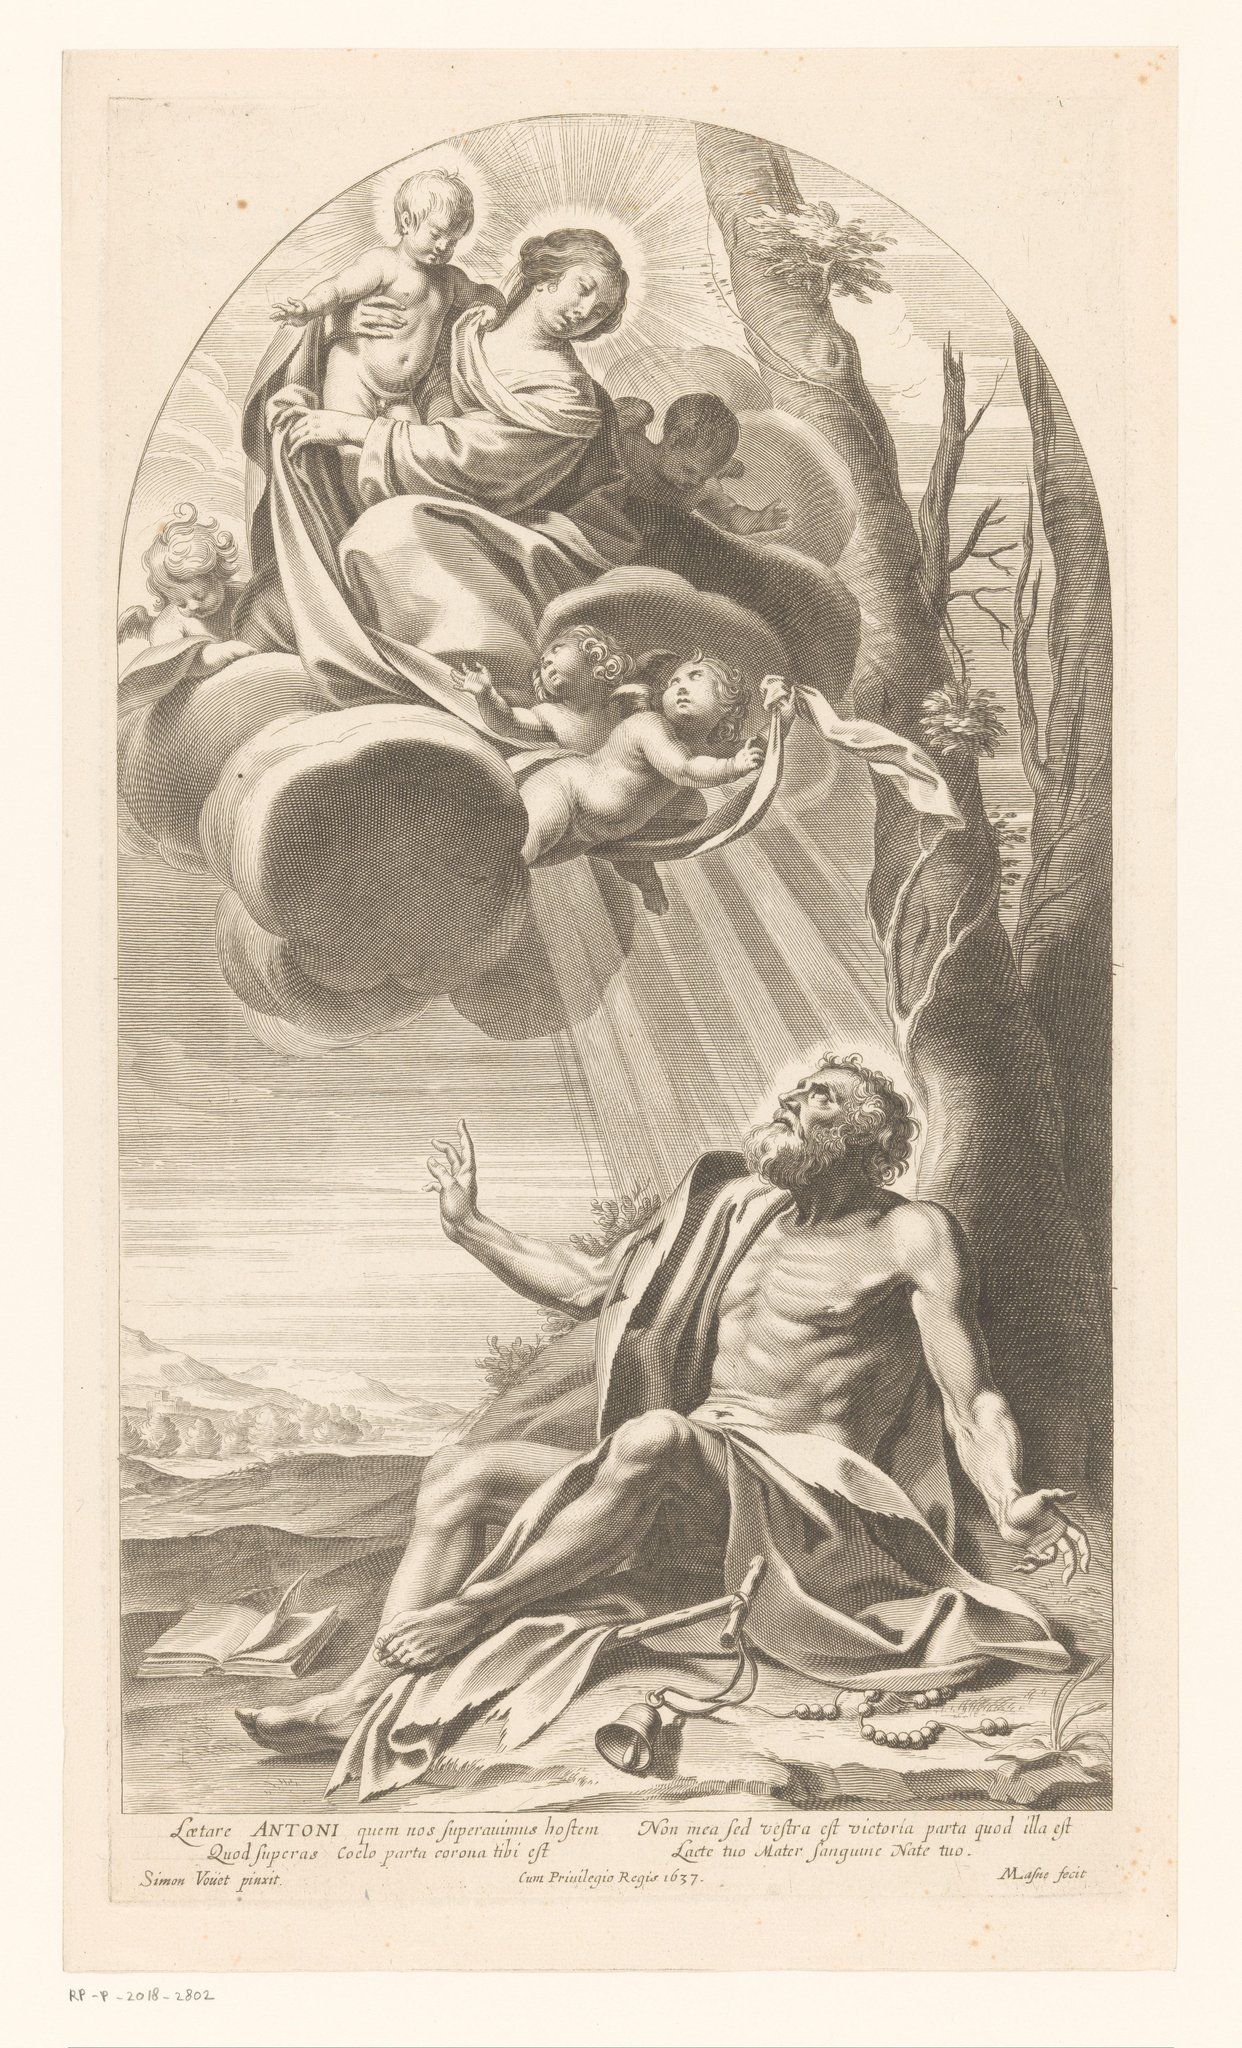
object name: print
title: Maagd verschijnt aan de H. Antonius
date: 1637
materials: paper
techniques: engraving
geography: france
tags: st. antony abbot retreats into the desert, after having given away his possessions to the poor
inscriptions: date